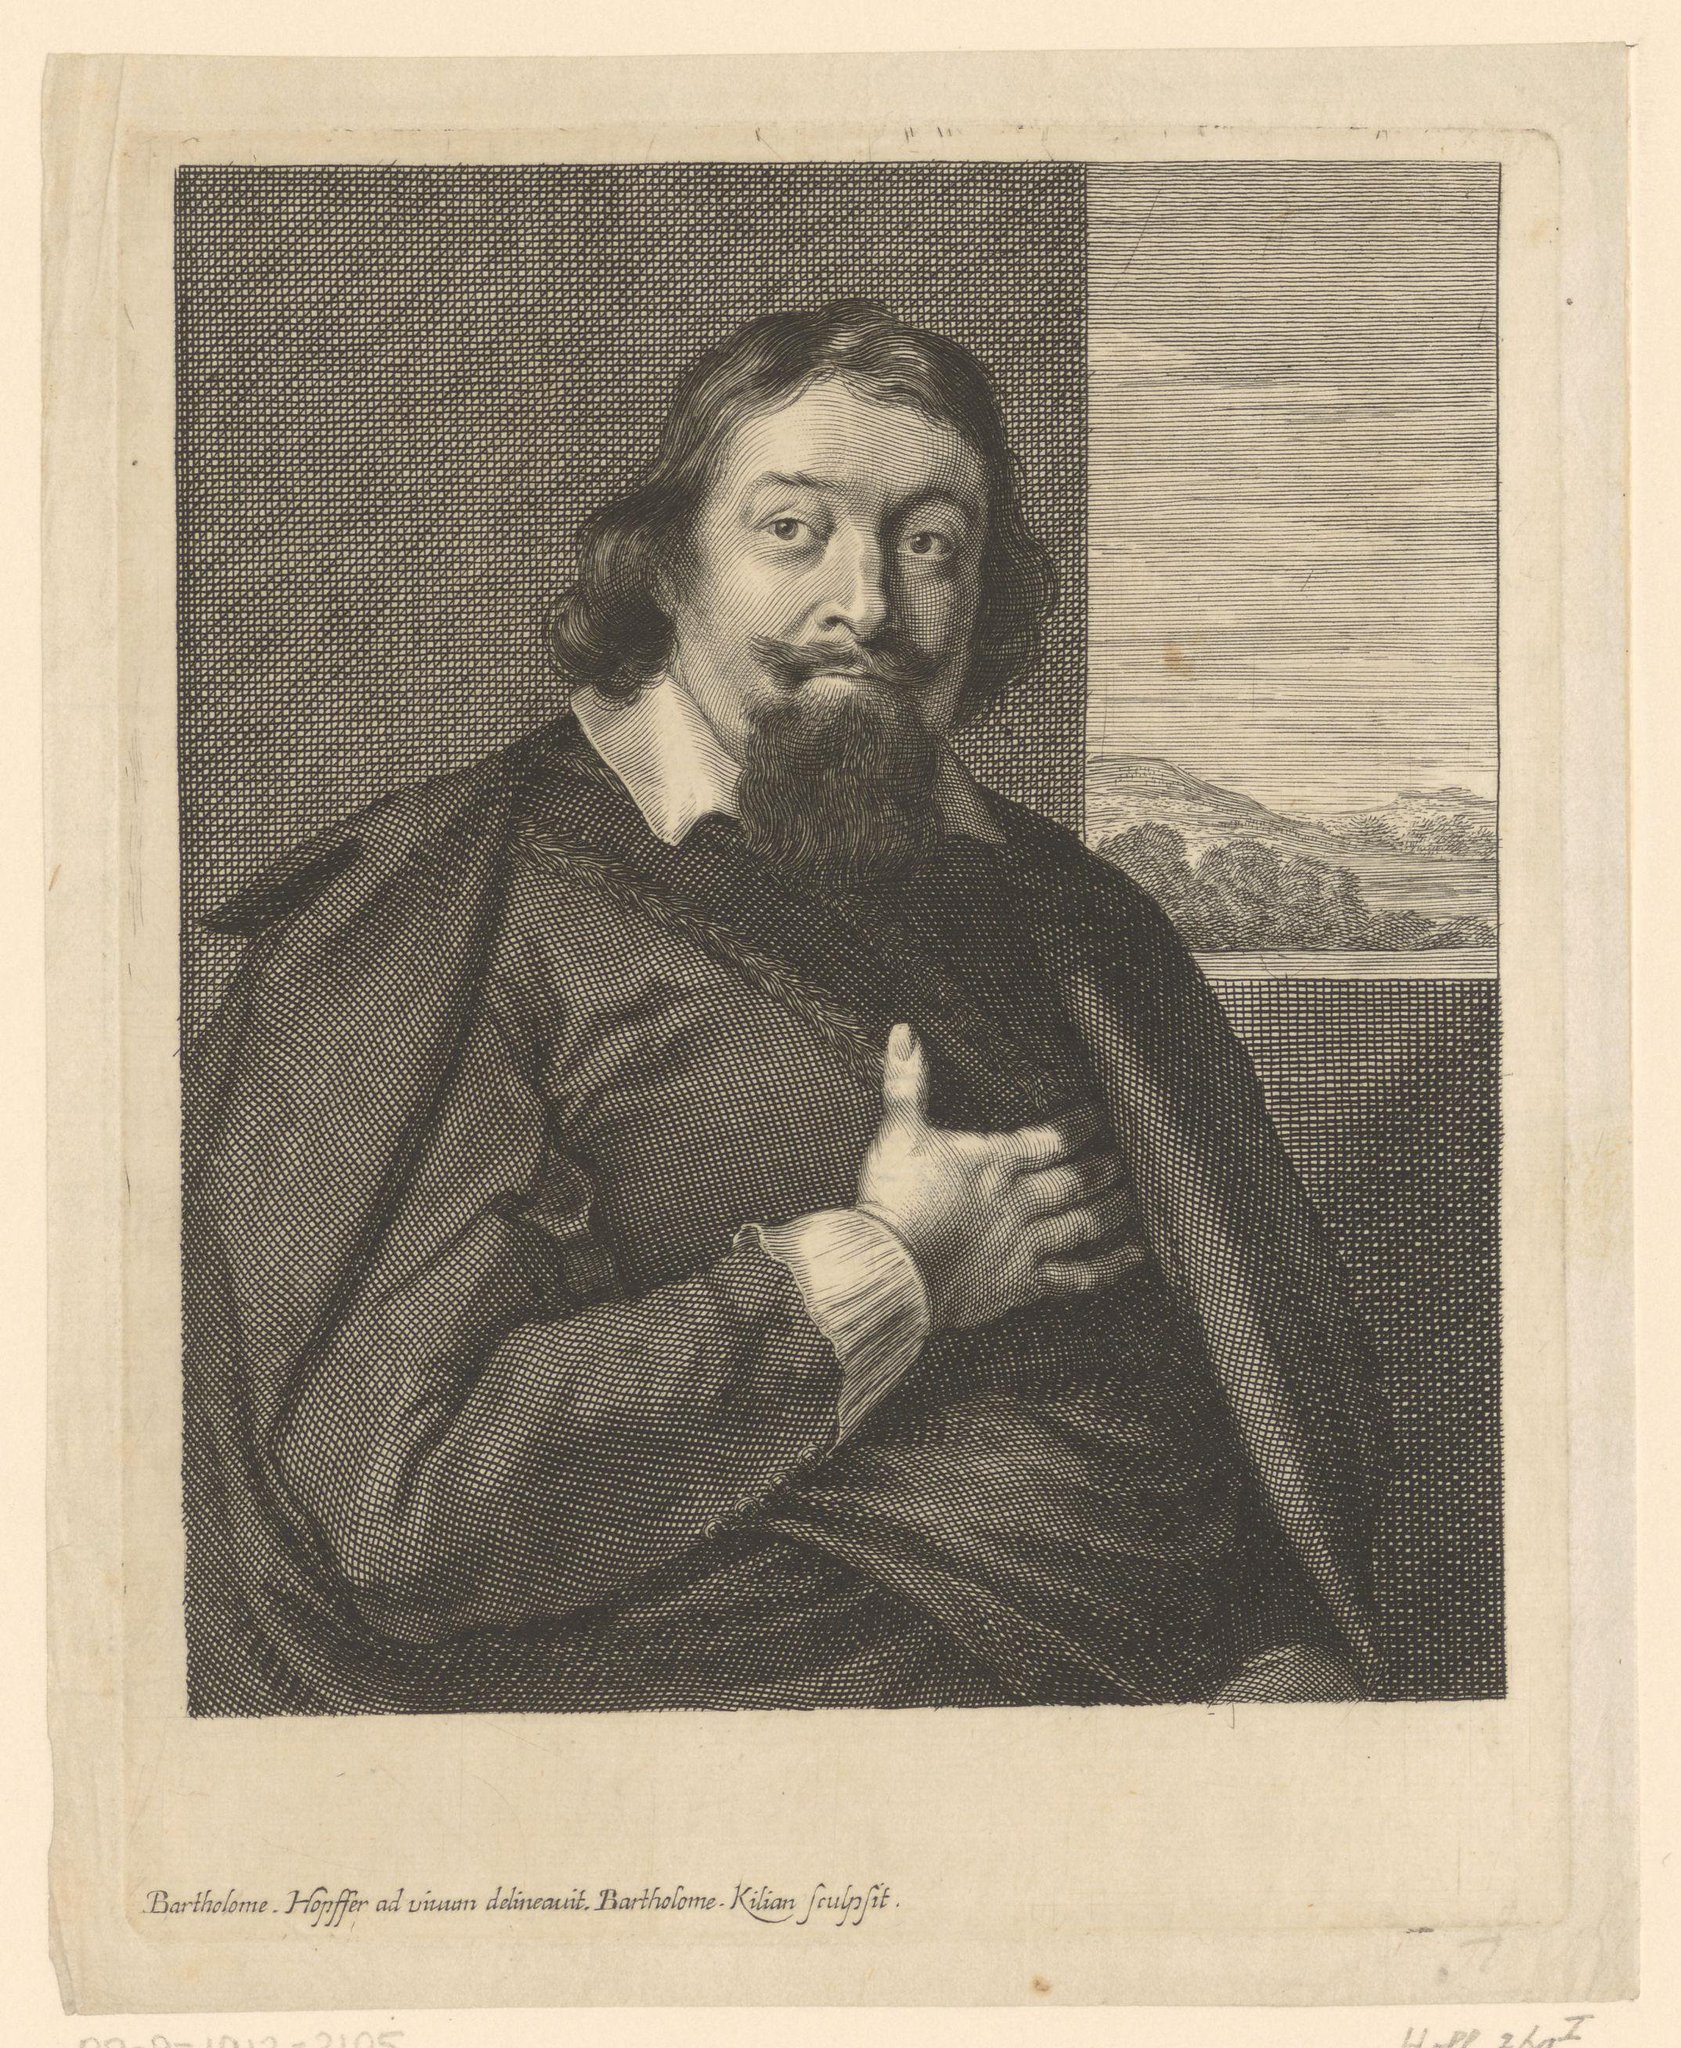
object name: print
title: Portret van Michael Miller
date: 1664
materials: paper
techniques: engraving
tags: historical persons, merchant, salesman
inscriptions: collector's mark: Lugt 2228